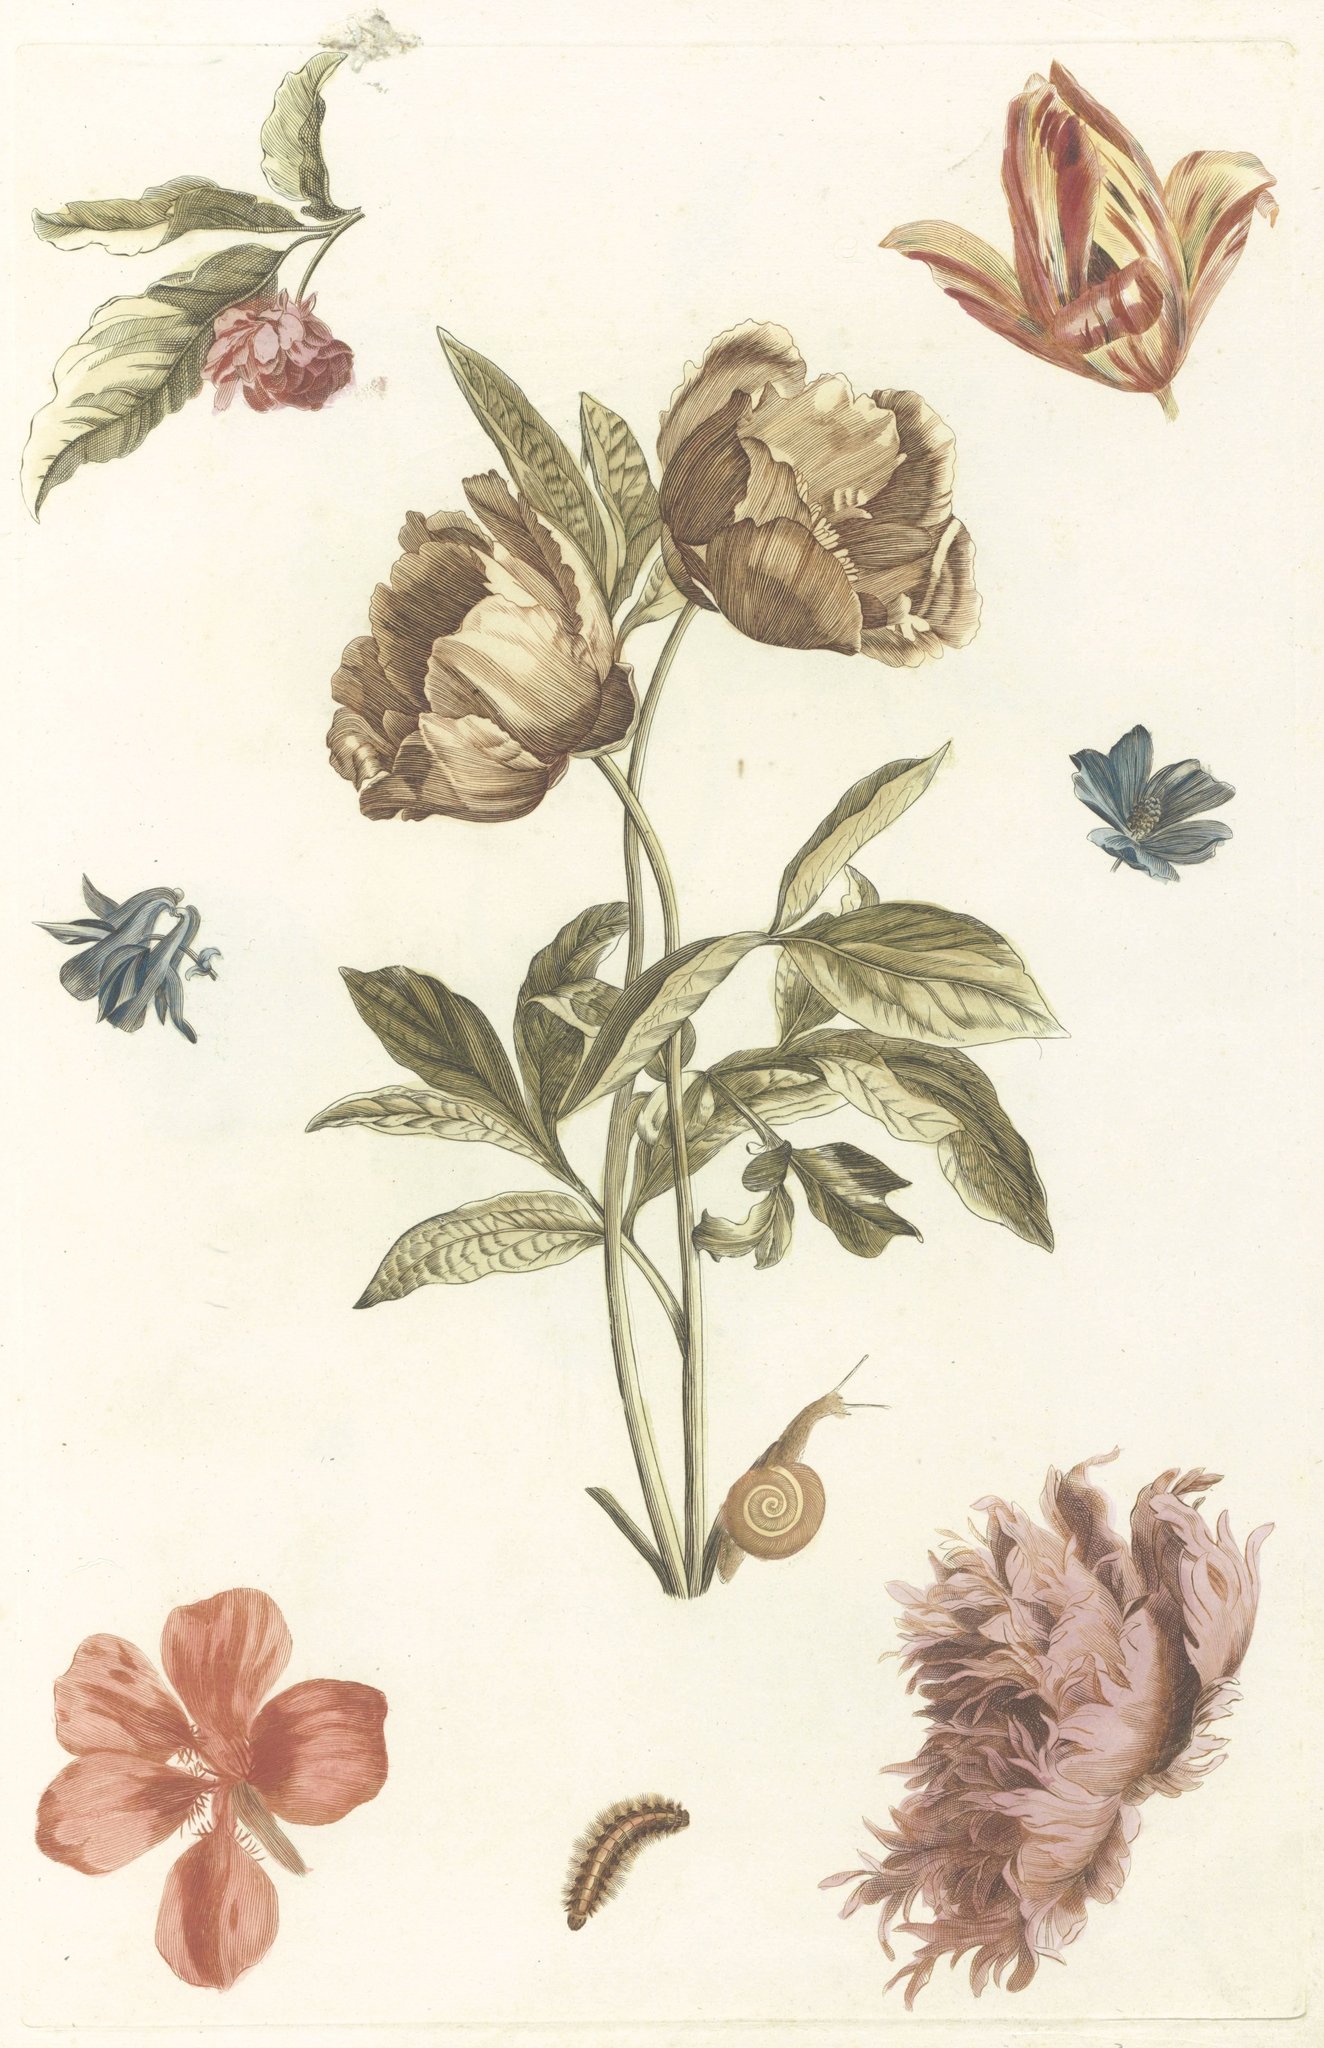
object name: album leaf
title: Verschillende bloemen en een rups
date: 1688-1698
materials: paper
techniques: printing, engraving, lithography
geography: netherlands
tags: flowers: rose, flowers: tulip, insects: caterpillar, molluscs: snail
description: Twee bloemen met een slak op de steel. Rondom zes bloemen, waaronder akelei en tulp. Midden onder een rups. Deze prent maakt deel uit van een album.